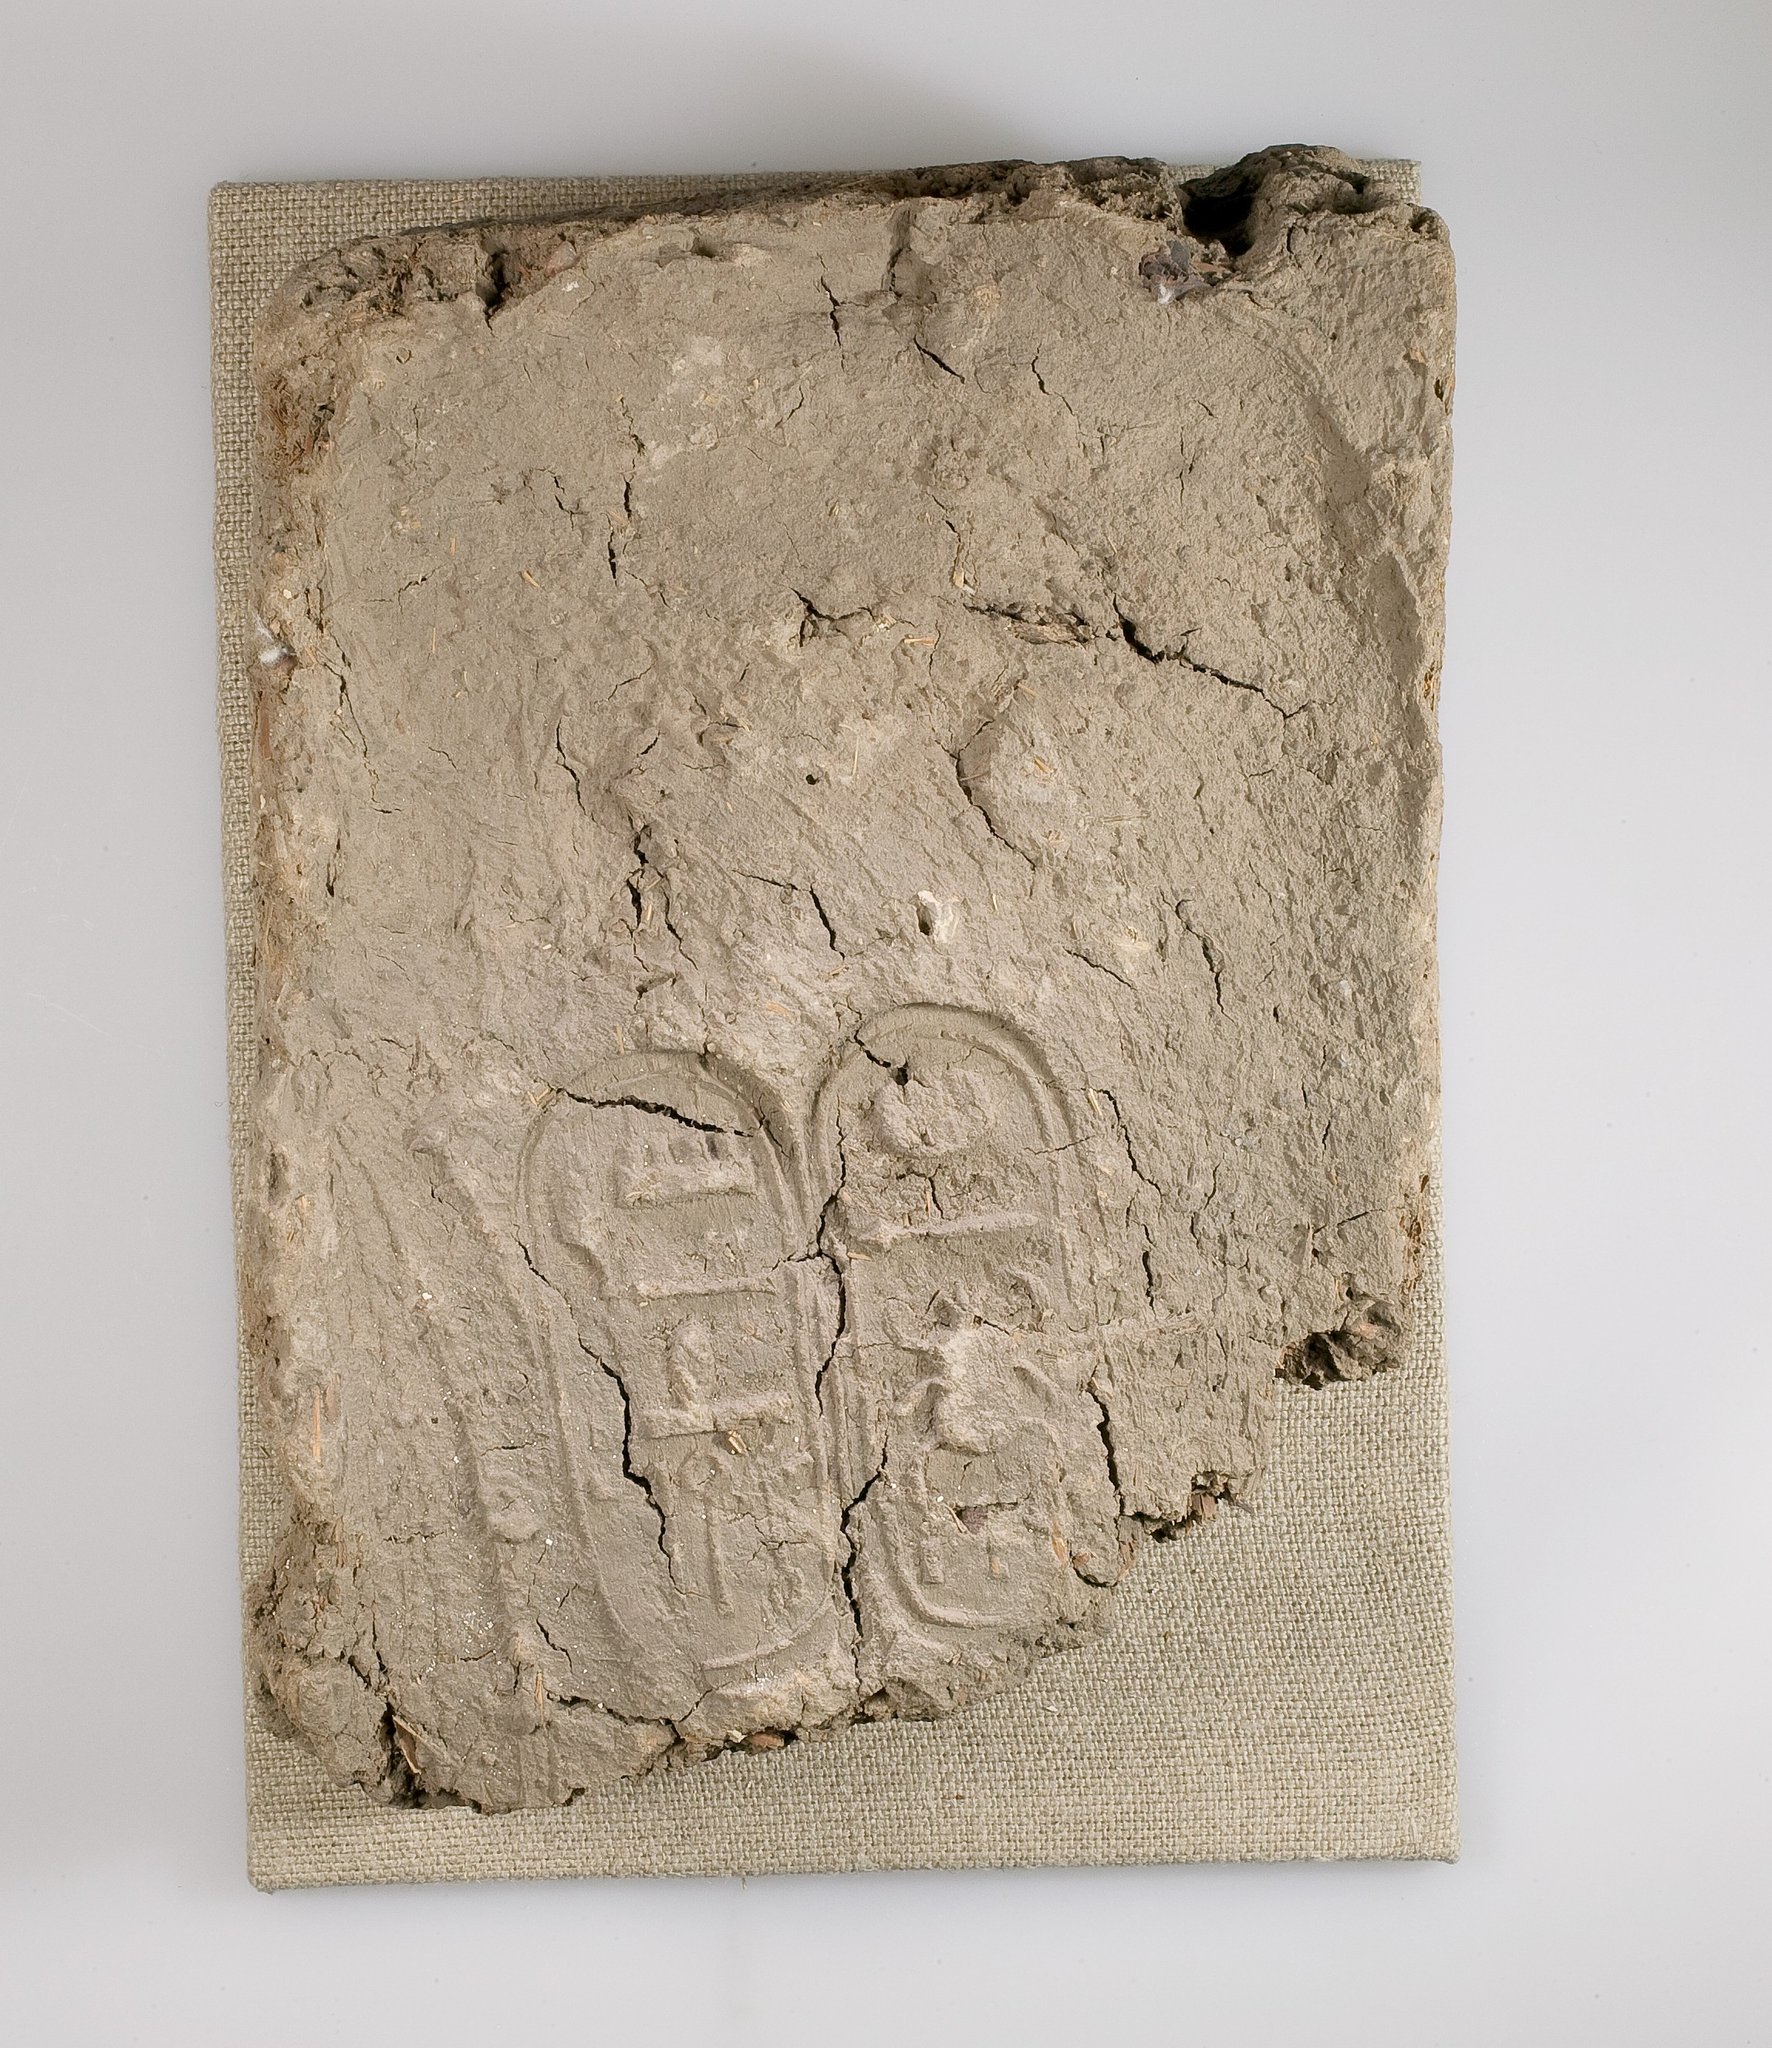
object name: brick, amenhotep ii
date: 1427-1400 BCE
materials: mud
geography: egypt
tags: cartouches,hieroglyphs